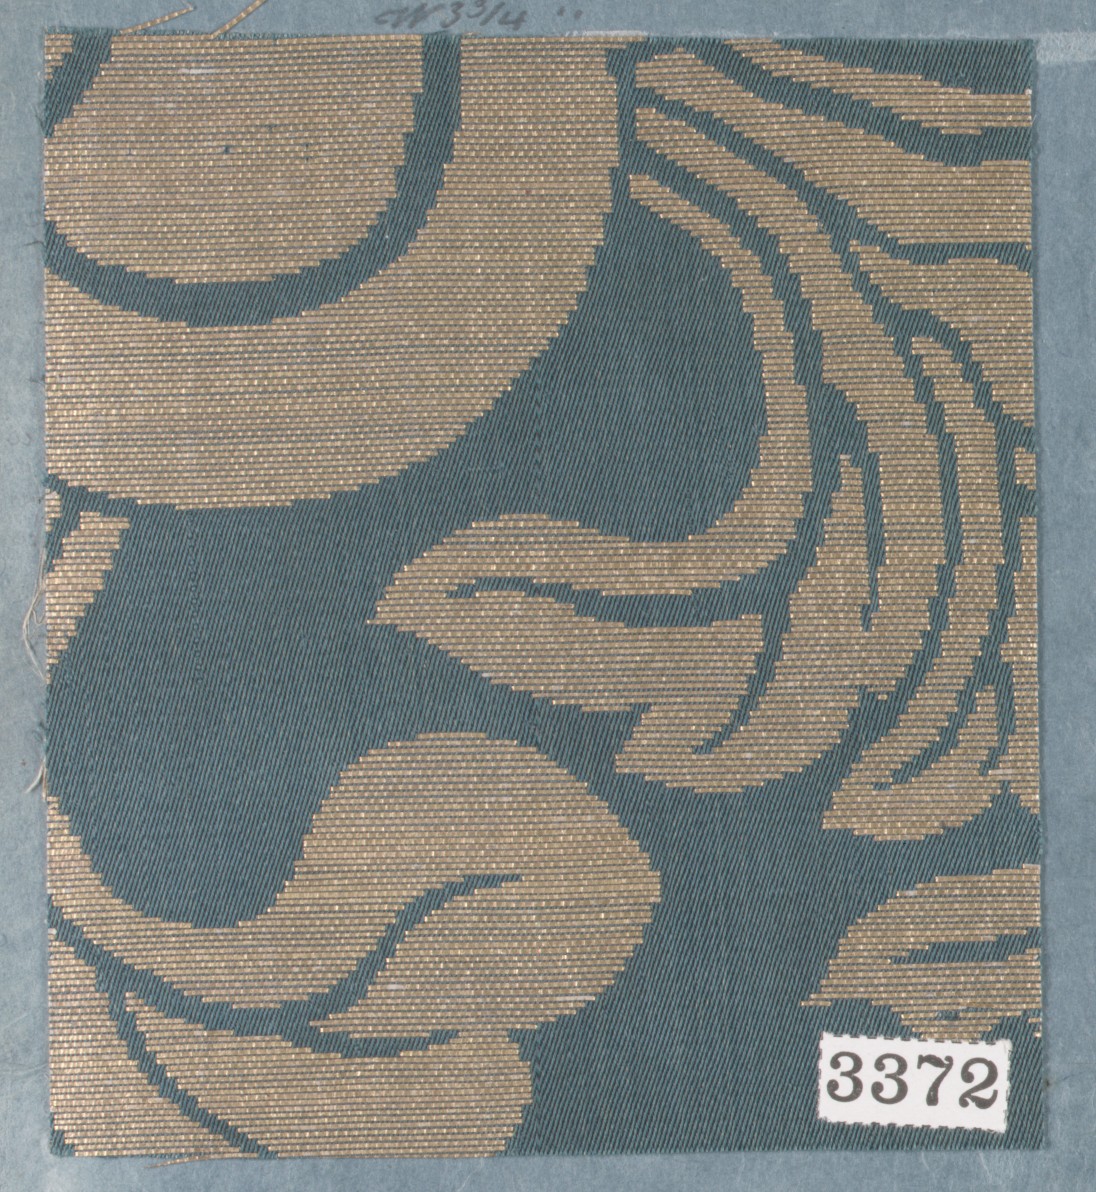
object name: textile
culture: japanese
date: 1801-1900